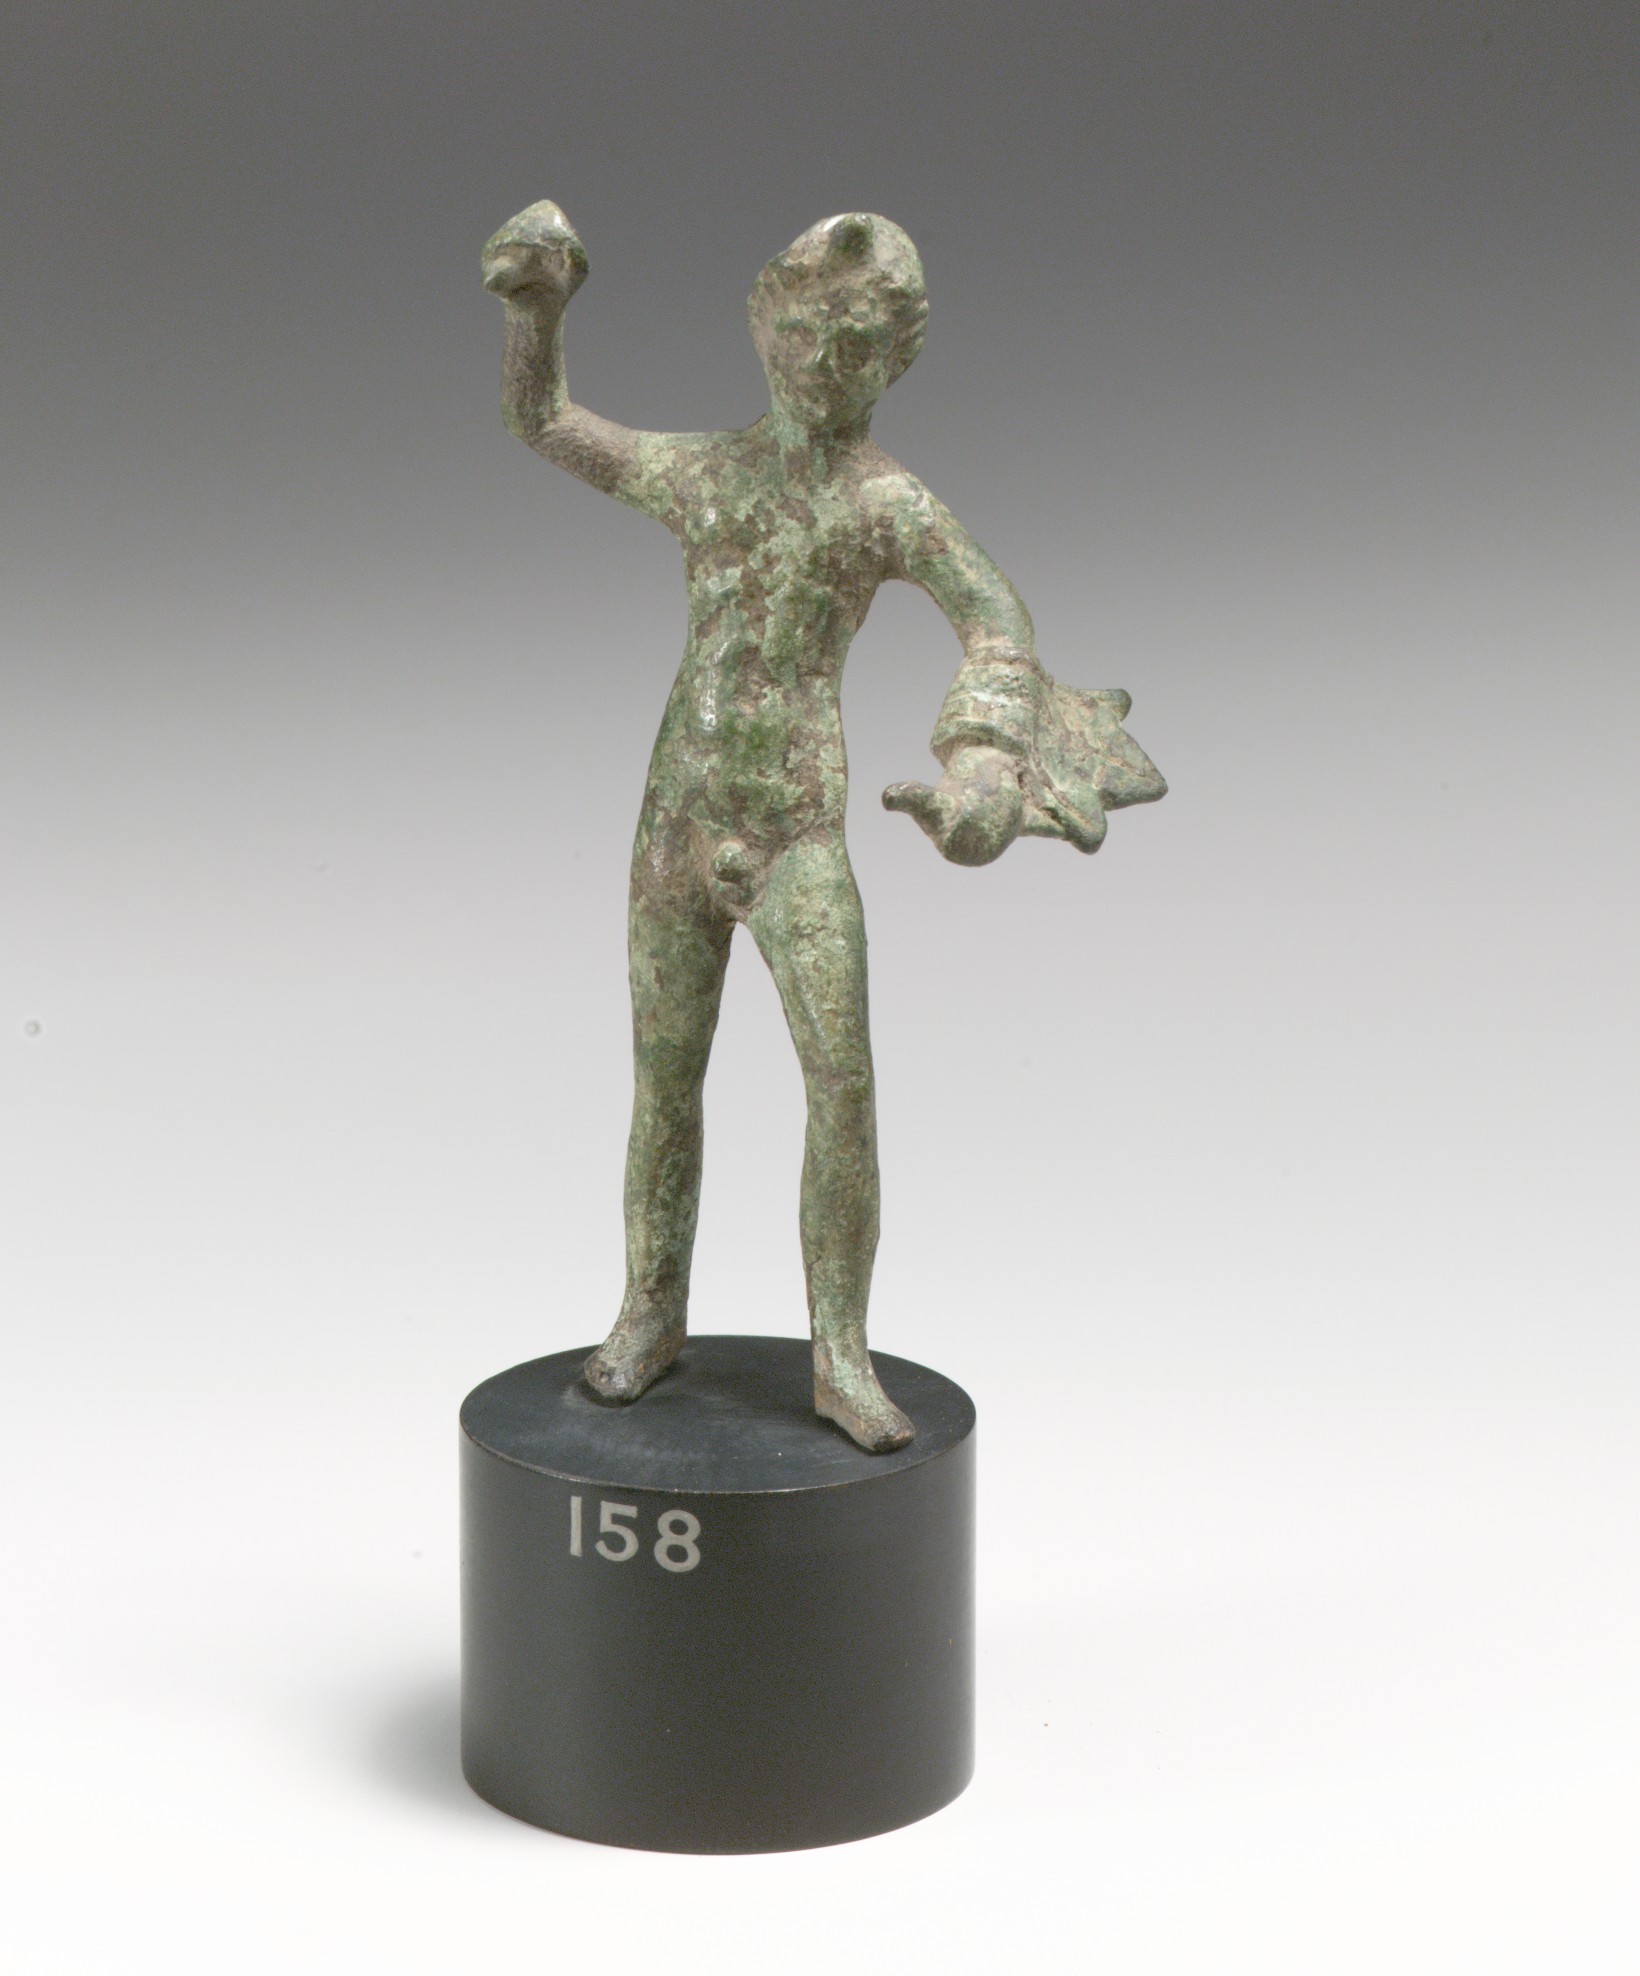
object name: statuette of herakles with fillet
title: Bronze statuette of Herakles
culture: italic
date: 300-1 BCE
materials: bronze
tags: herakles